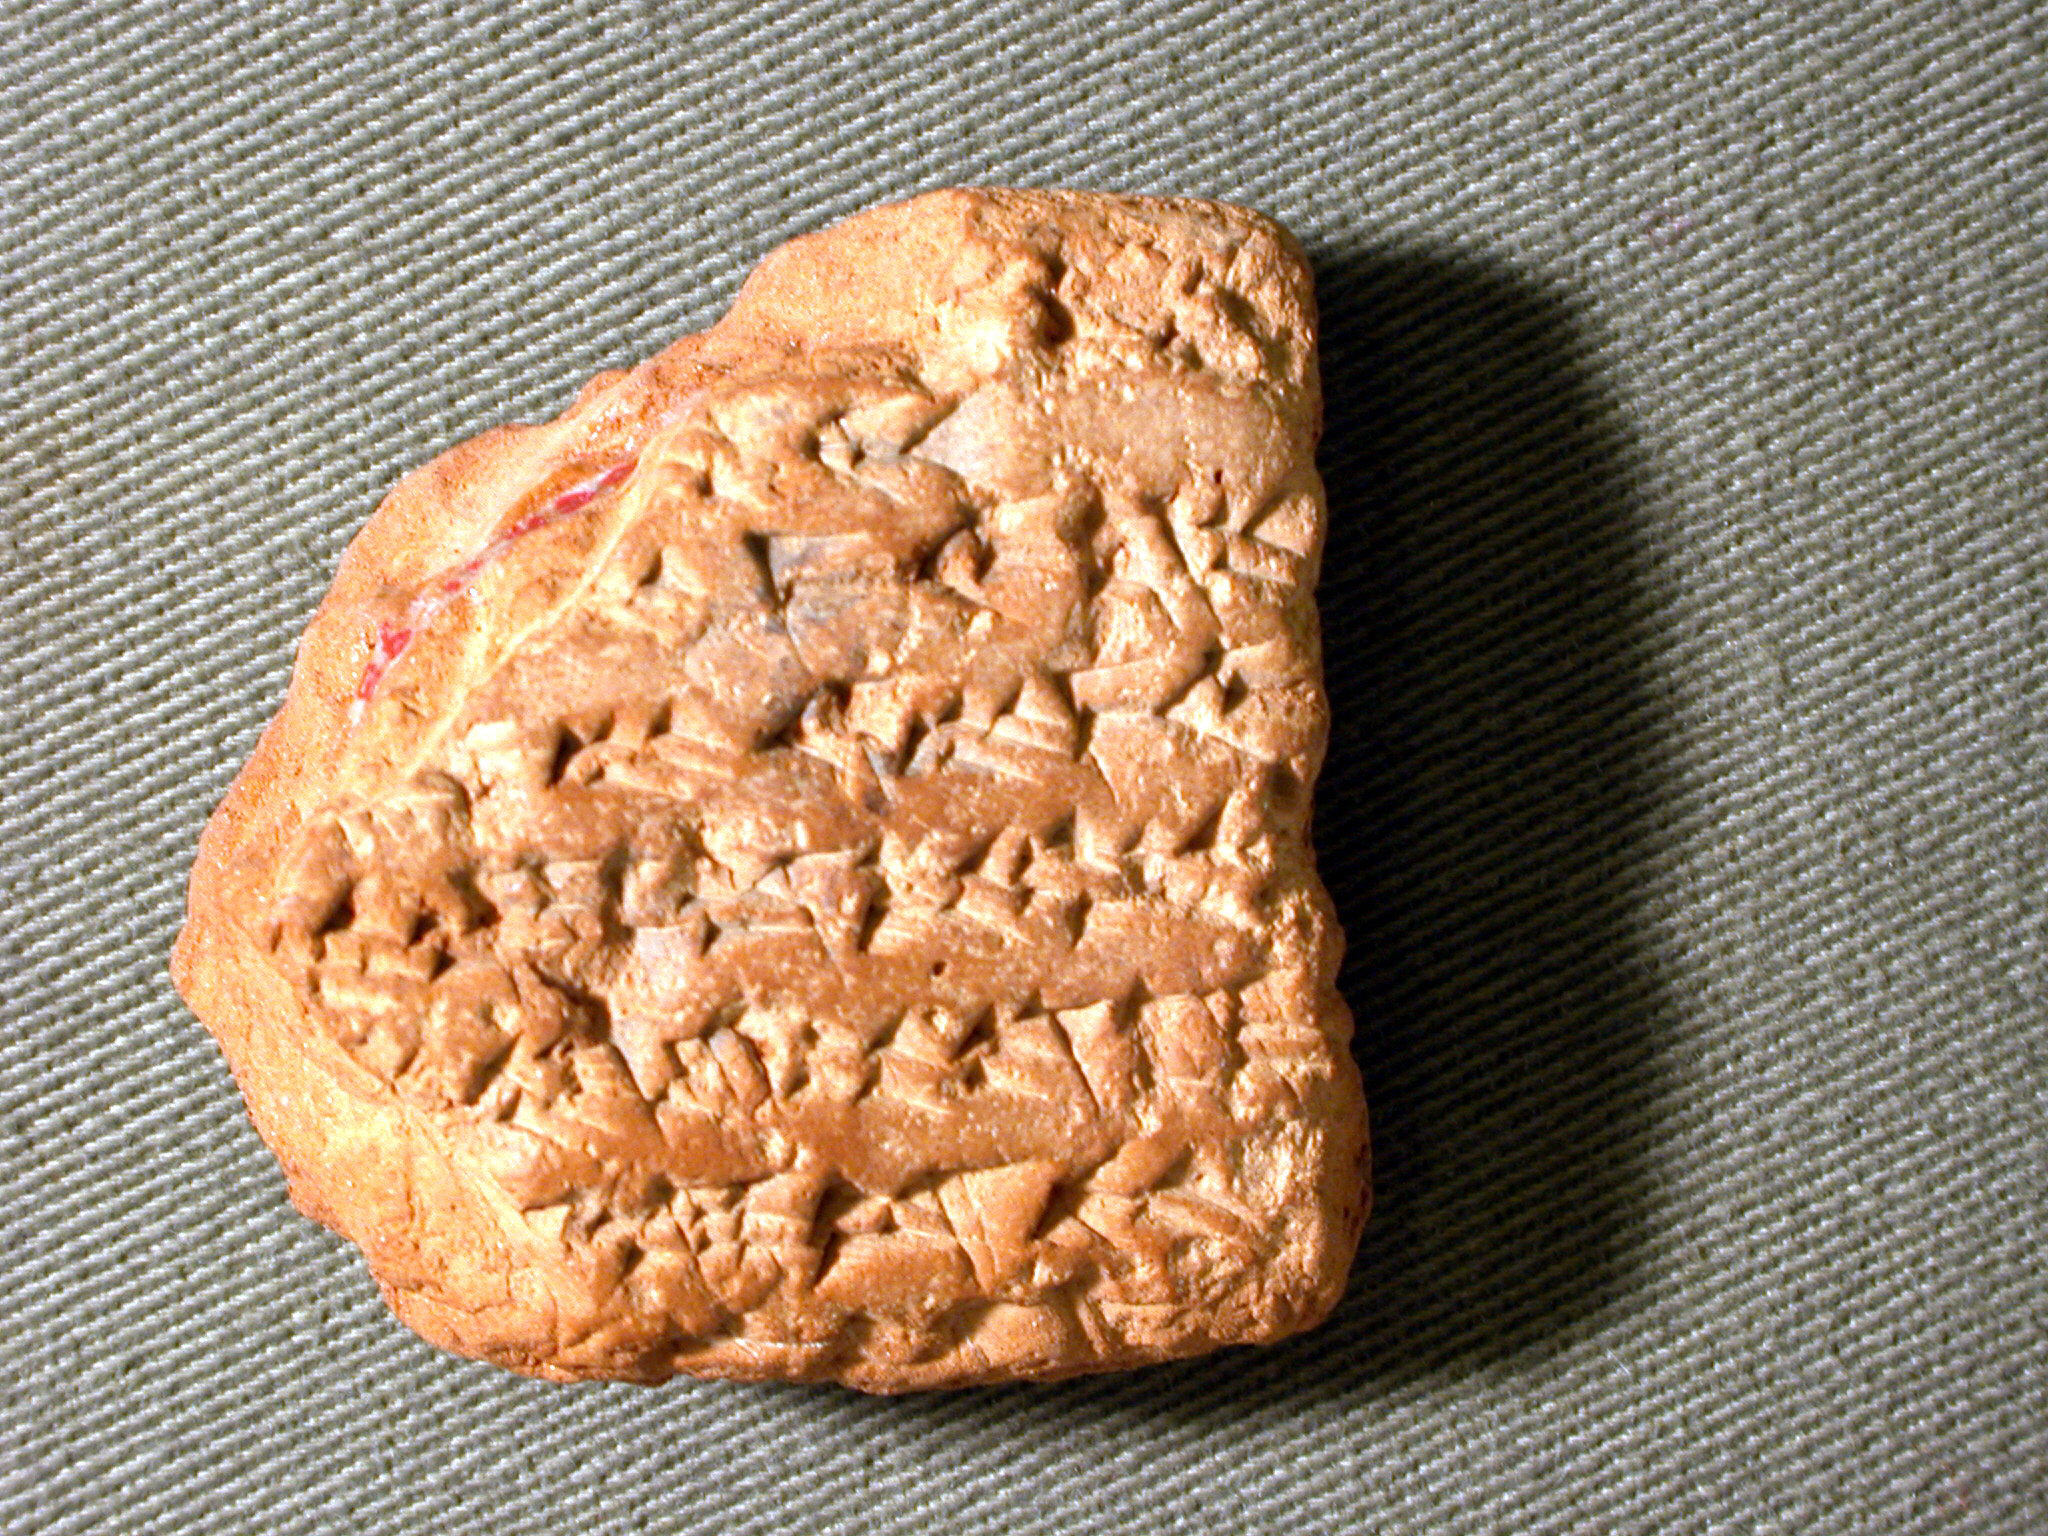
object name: cuneiform tablet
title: Cuneiform tablet: fragment, Ebabbar archive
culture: babylonian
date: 605-562 BCE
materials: clay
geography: mesopotamia